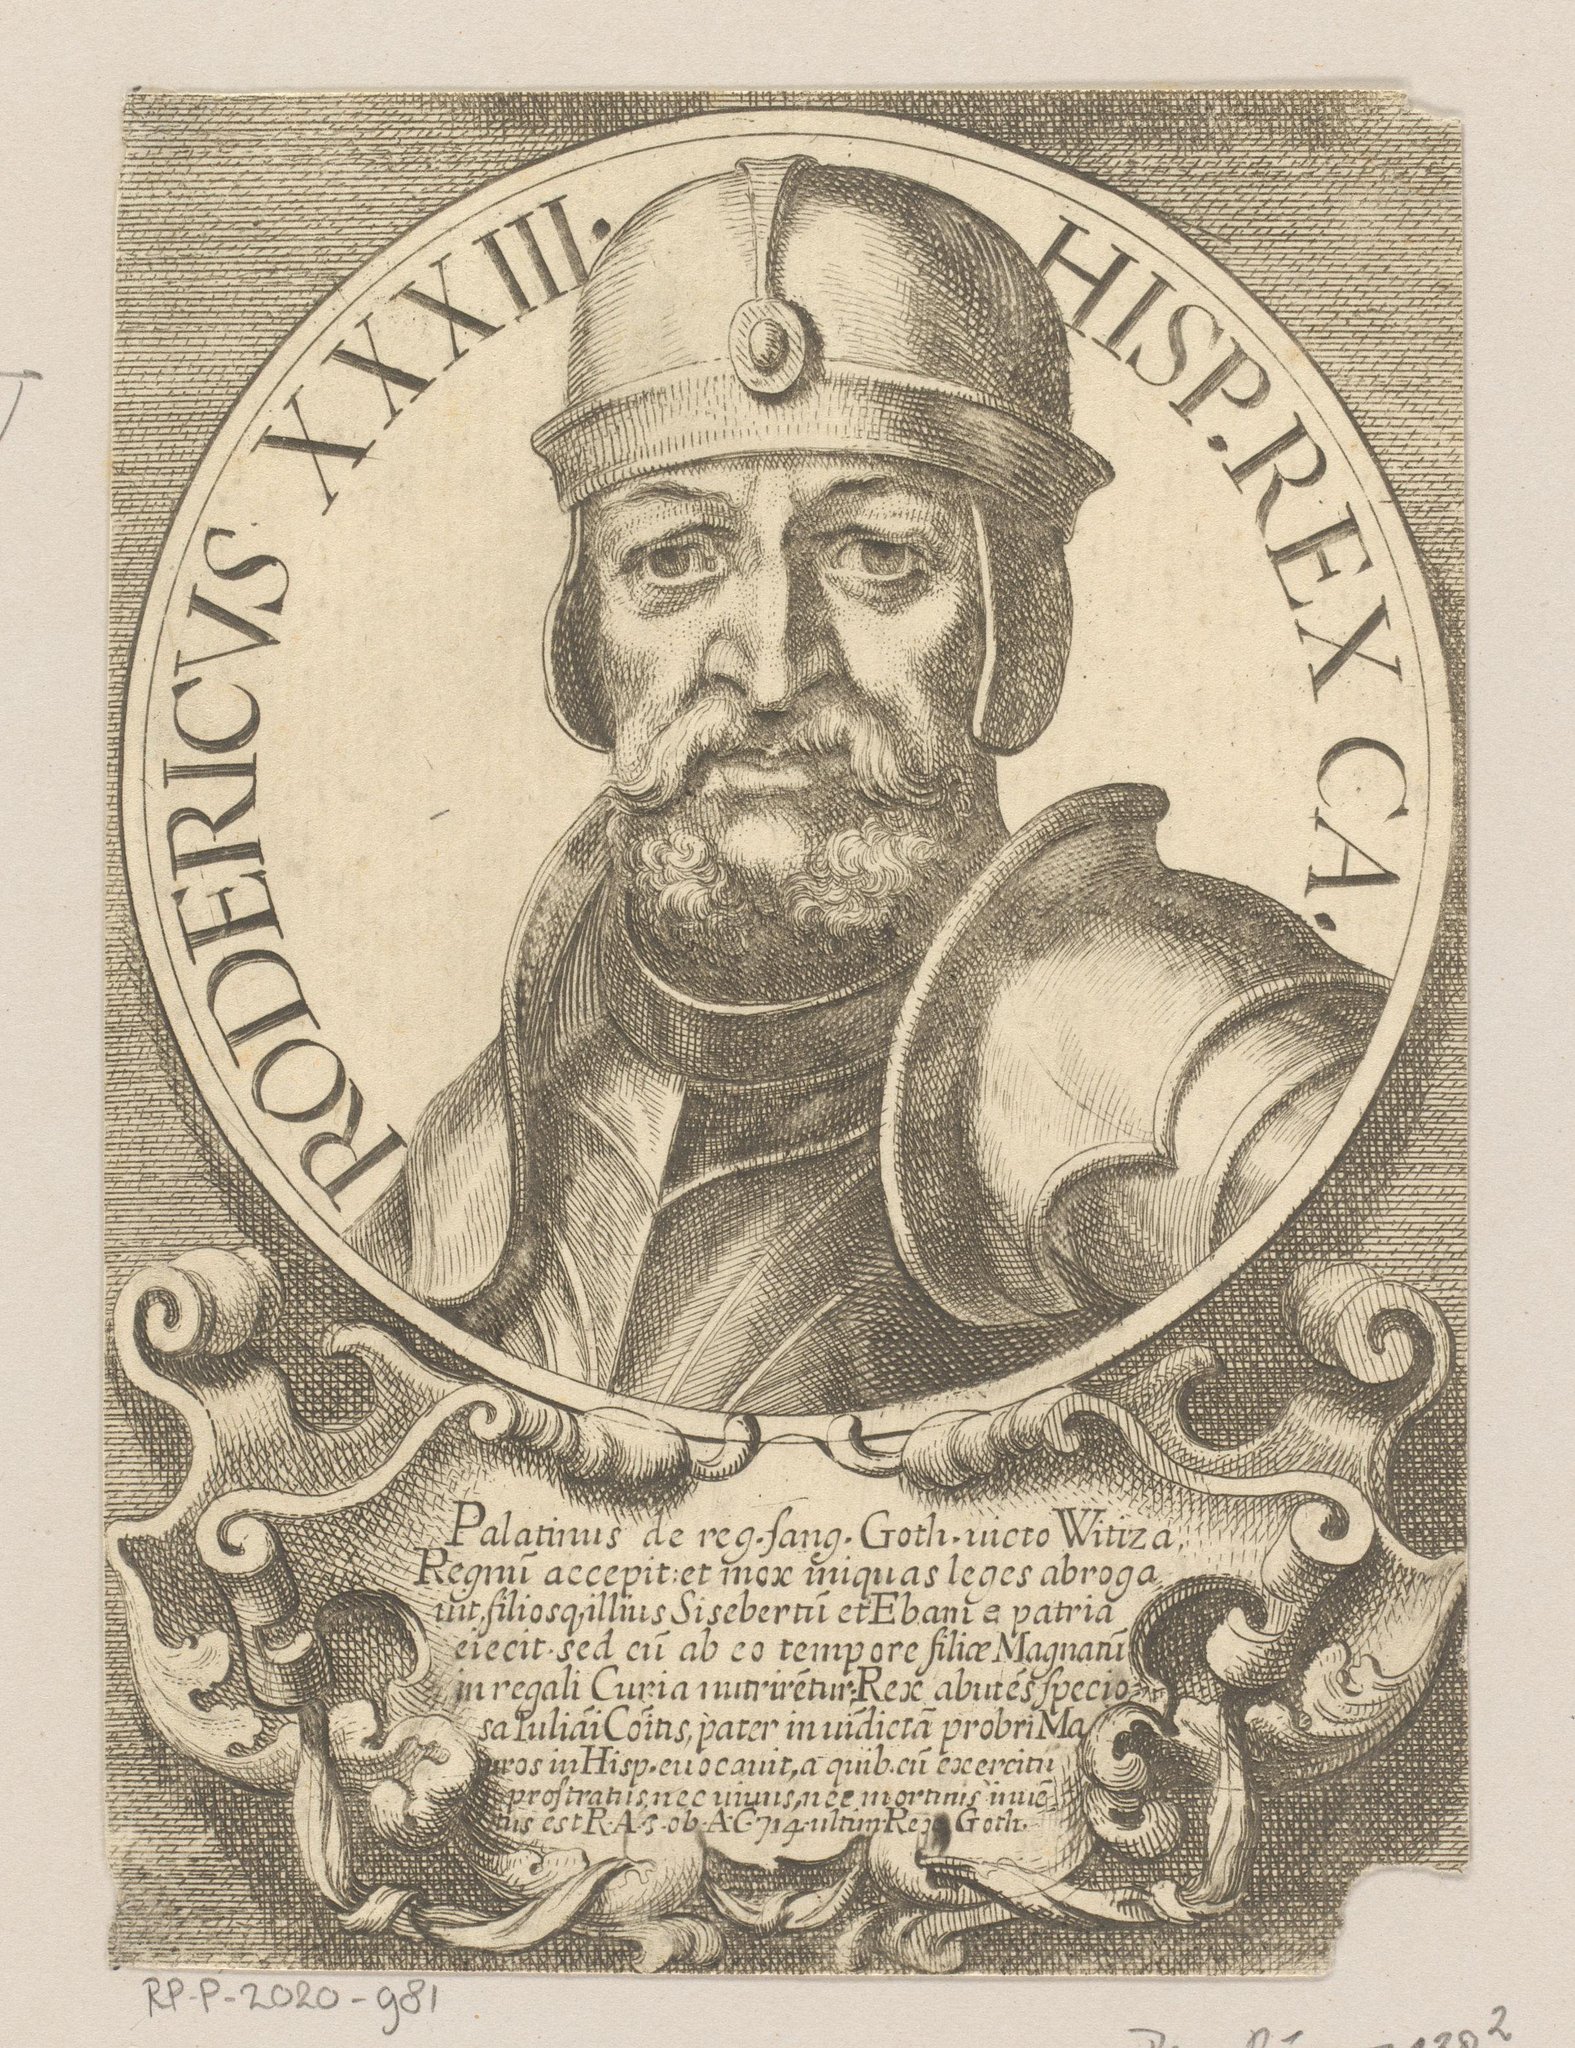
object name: print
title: Rodericus XXXIII Hisp Rex Ca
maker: arnold van westerhout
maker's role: print maker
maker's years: 1651-1725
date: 1684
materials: paper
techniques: engraving, etching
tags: historical persons, ruler, sovereign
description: Portret ook gebruikt in: Niphus, Agustinus. Effigies et series regum Hispaniae primum ex Gothis Christianorum (...). Rome: s.n., 1684.